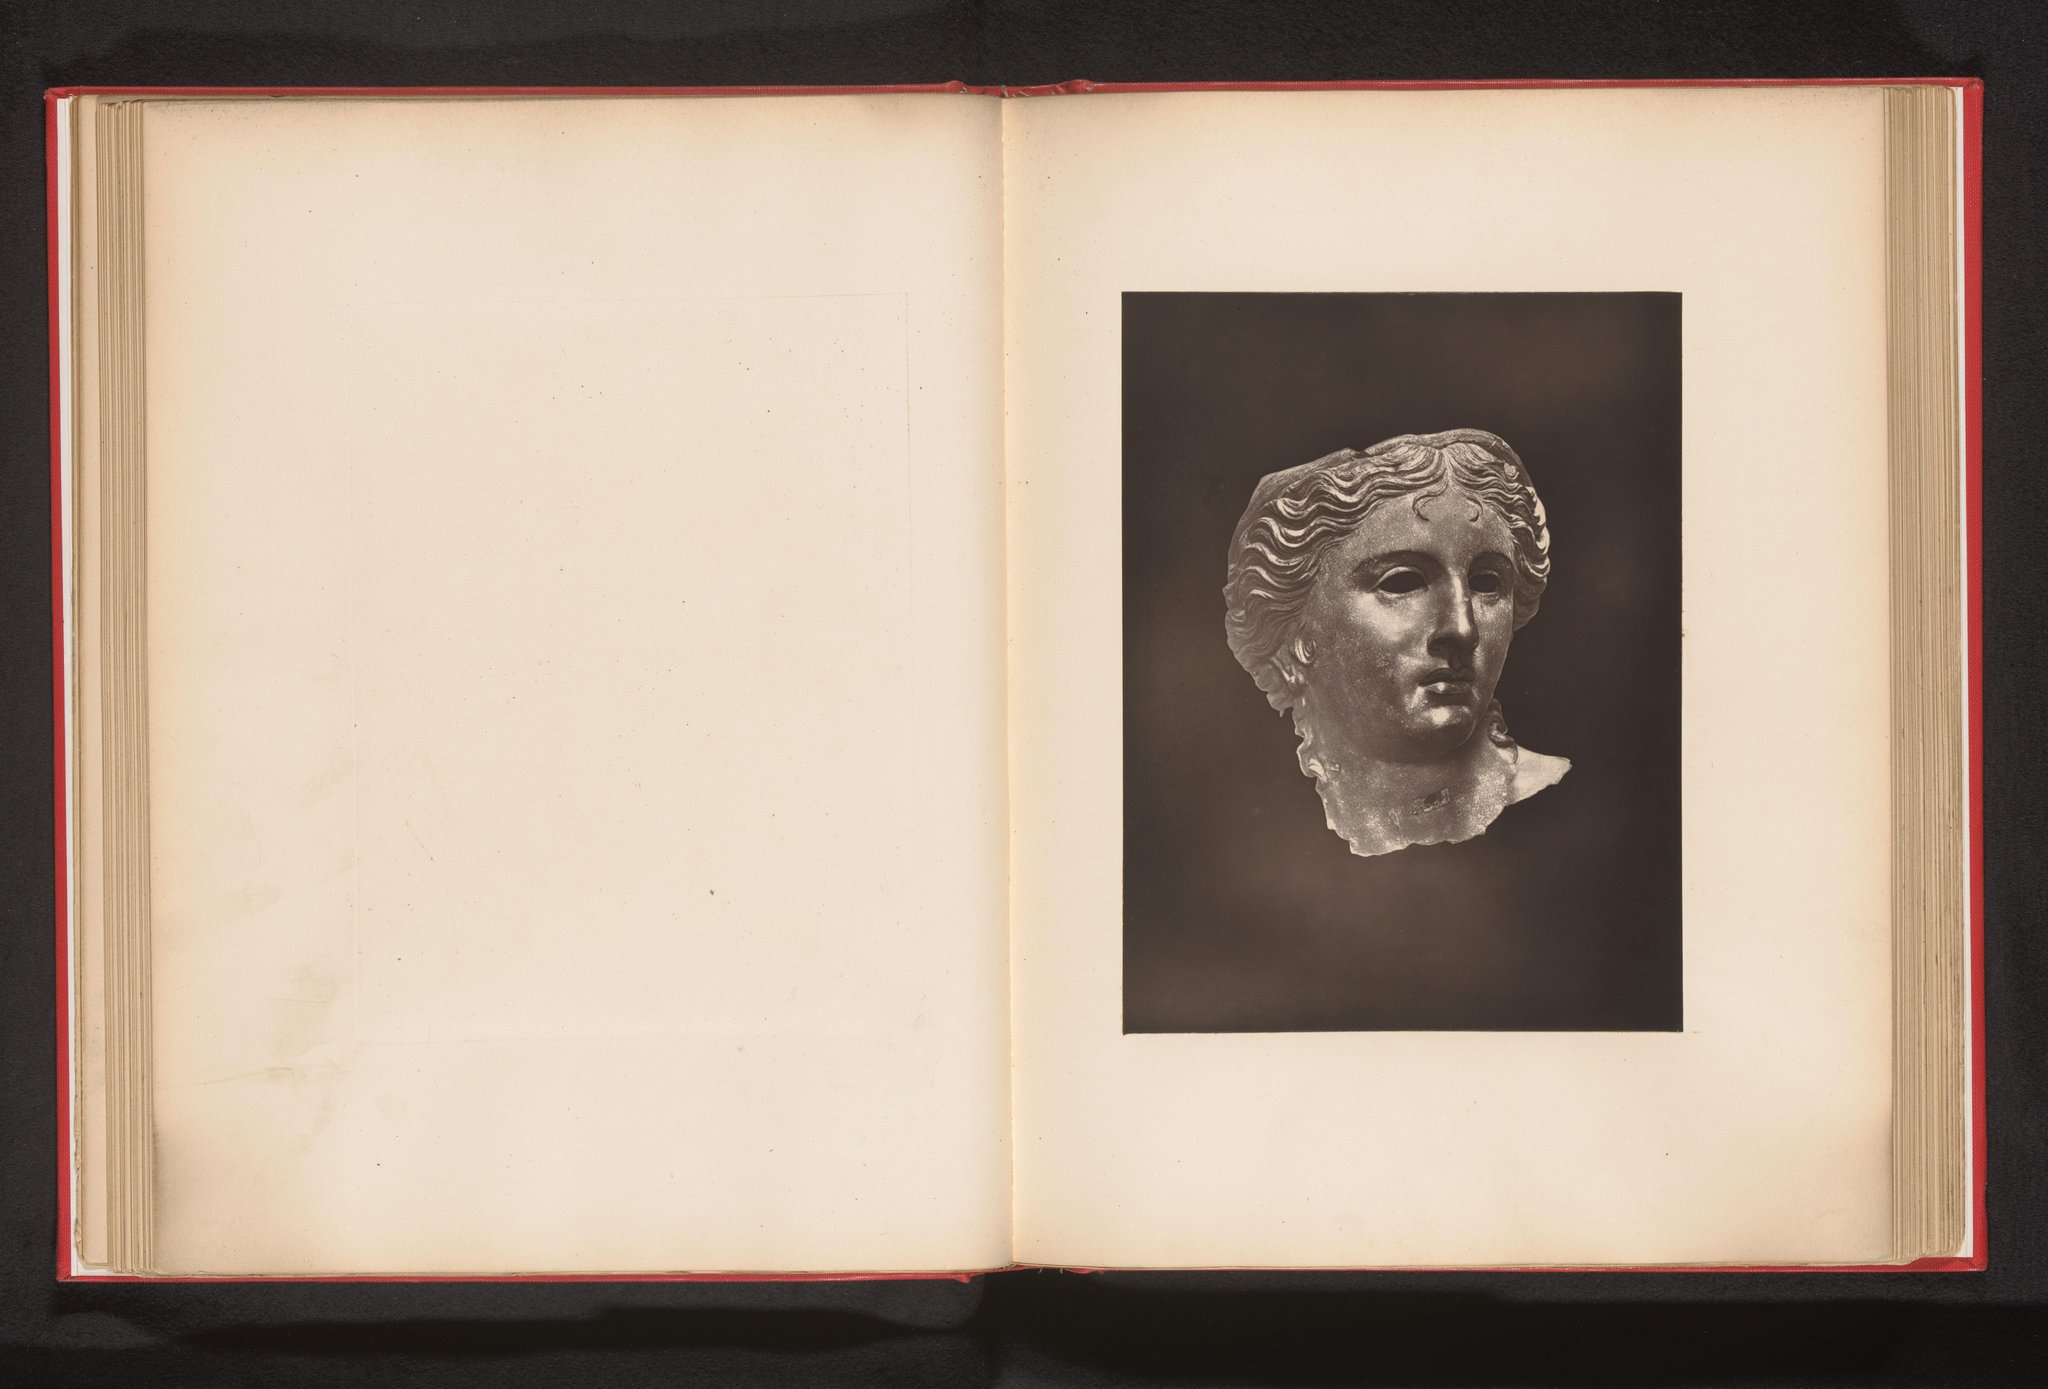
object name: photomechanical print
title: Hoofd van Aphrodite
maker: stephen thompson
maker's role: fotograaf, schrijver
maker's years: 1831-1893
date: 1873-1878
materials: paper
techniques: woodburytype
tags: (story of) venus (aphrodite), sculpture